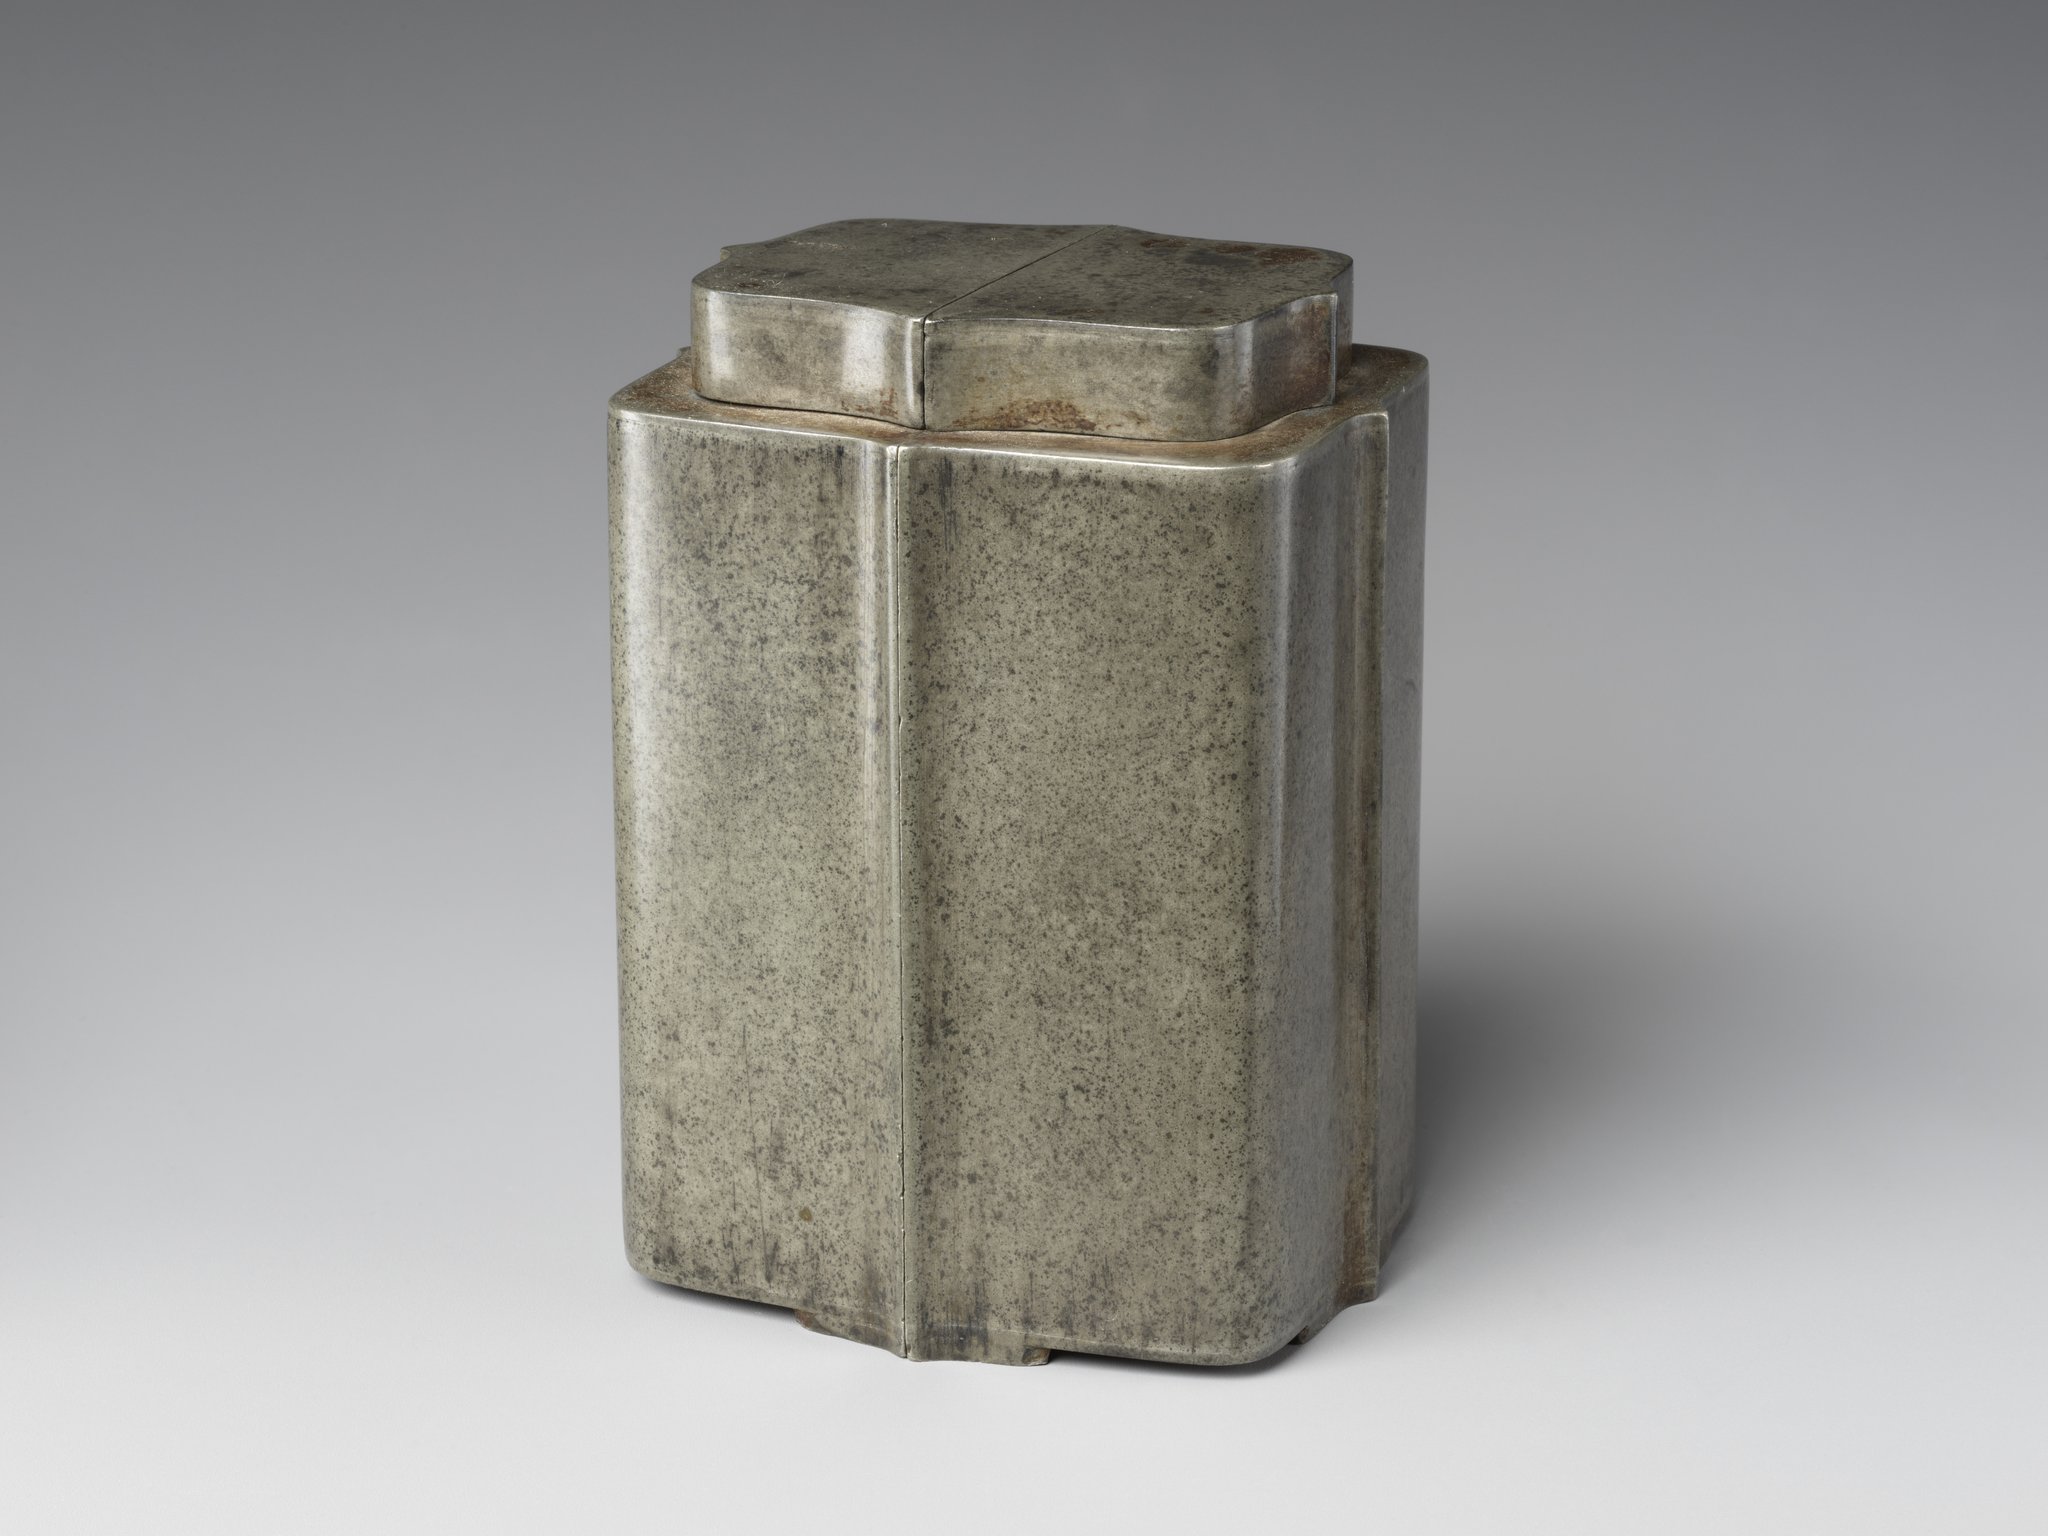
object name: tea caddy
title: Pair of inscribed tea caddies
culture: chinese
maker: shen cunzhou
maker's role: artist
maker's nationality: chinese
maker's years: 1600-1699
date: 1601-1700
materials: pewter